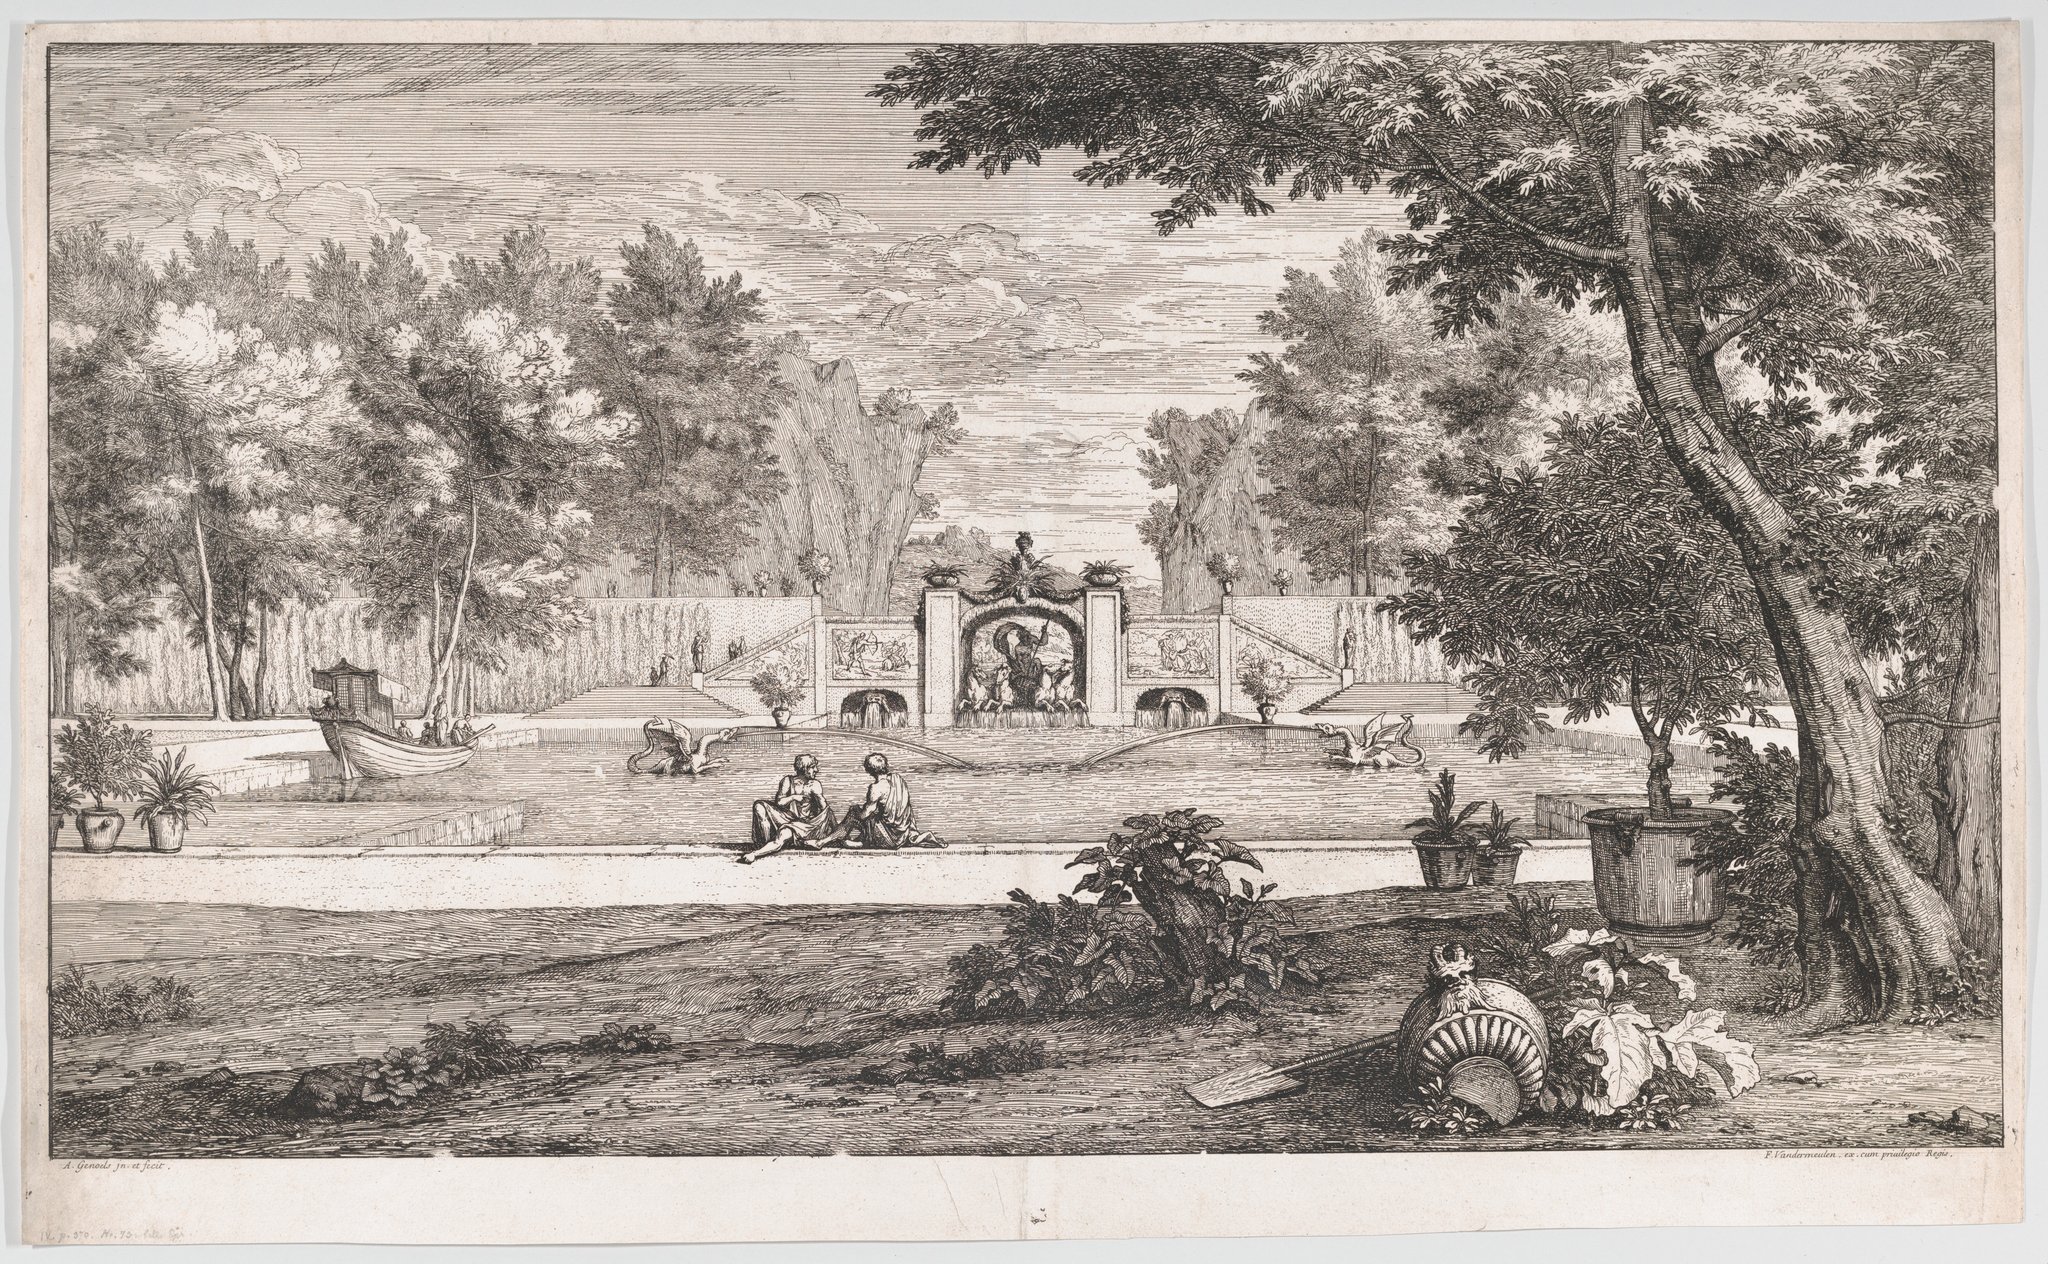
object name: print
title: Grand Garden View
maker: abraham genoels ii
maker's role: artist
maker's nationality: flemish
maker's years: 1640-1723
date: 1655-1690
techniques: etching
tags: gardens,landscapes,boats